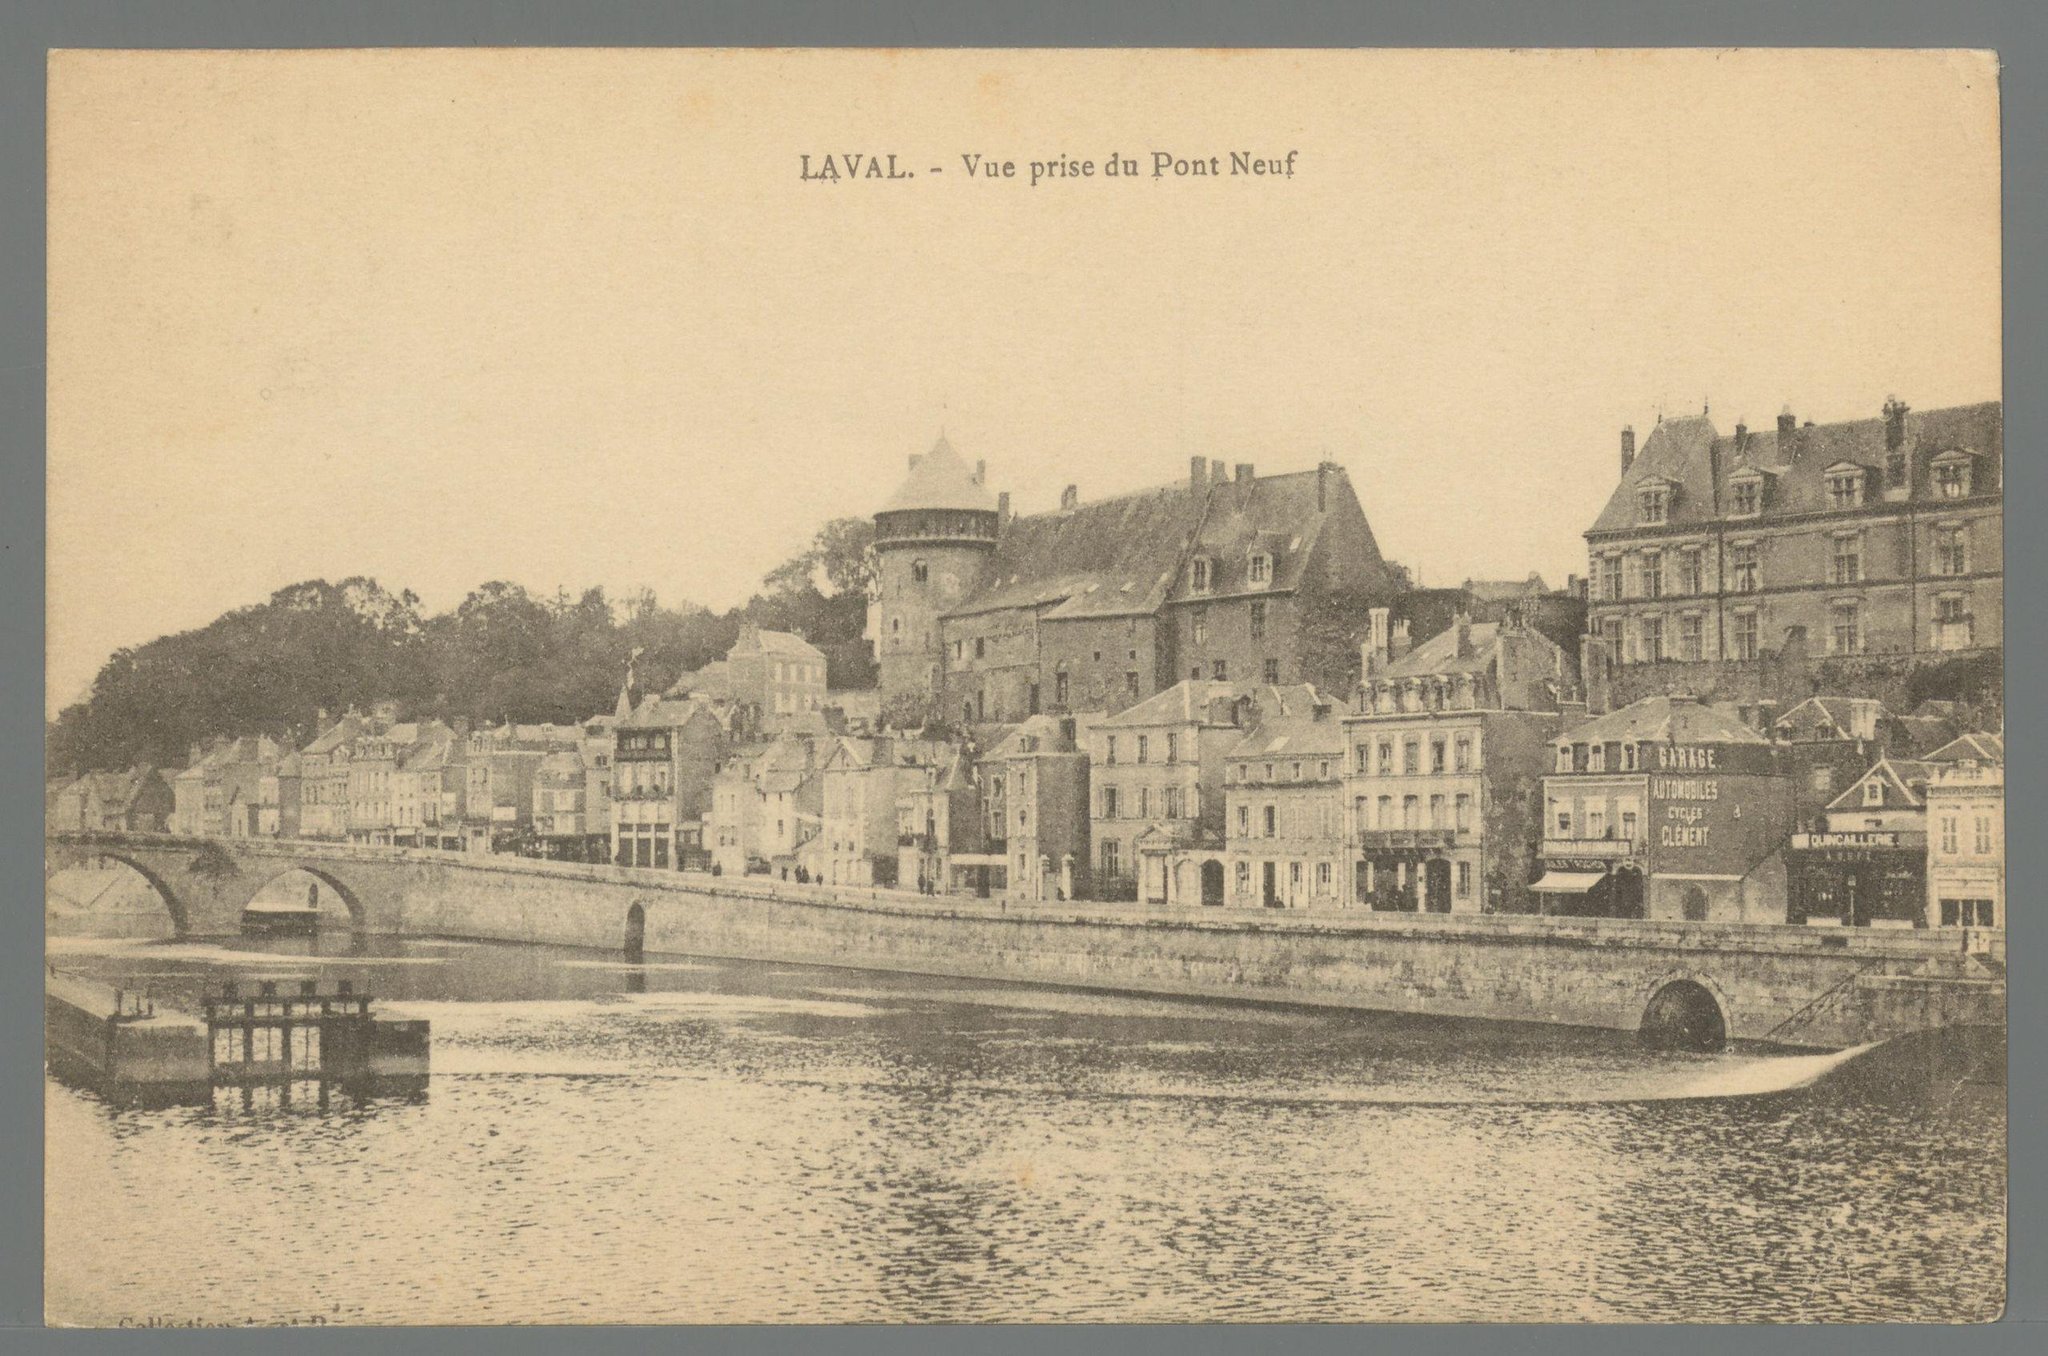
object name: photomechanical print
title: Laval. Vue prise du Pont Neuf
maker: Anonymous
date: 1903-1912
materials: cardboard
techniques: photograph, writing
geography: laval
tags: river, prospect of city, town panorama, silhouette of city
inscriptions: postage stamp